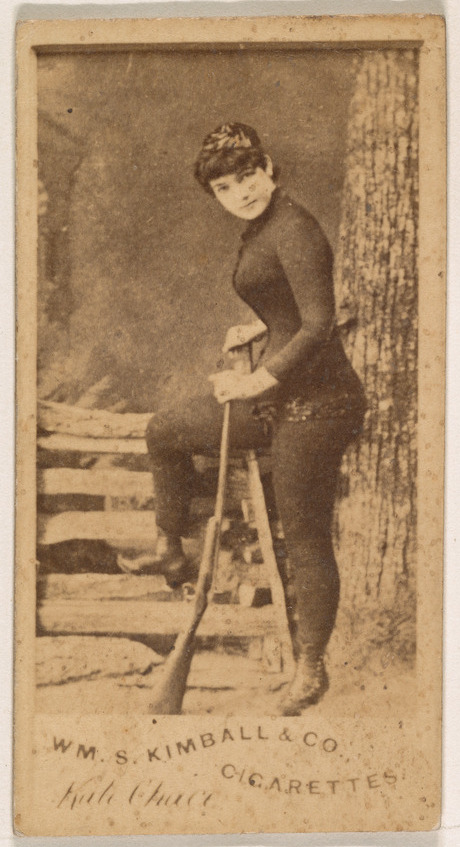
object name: photograph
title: Kate Chaice, from the Actresses series (N203) issued by Wm. S. Kimball & Co.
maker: william s. kimball & company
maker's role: publisher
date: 1889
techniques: color lithograph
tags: portraits,women,actresses